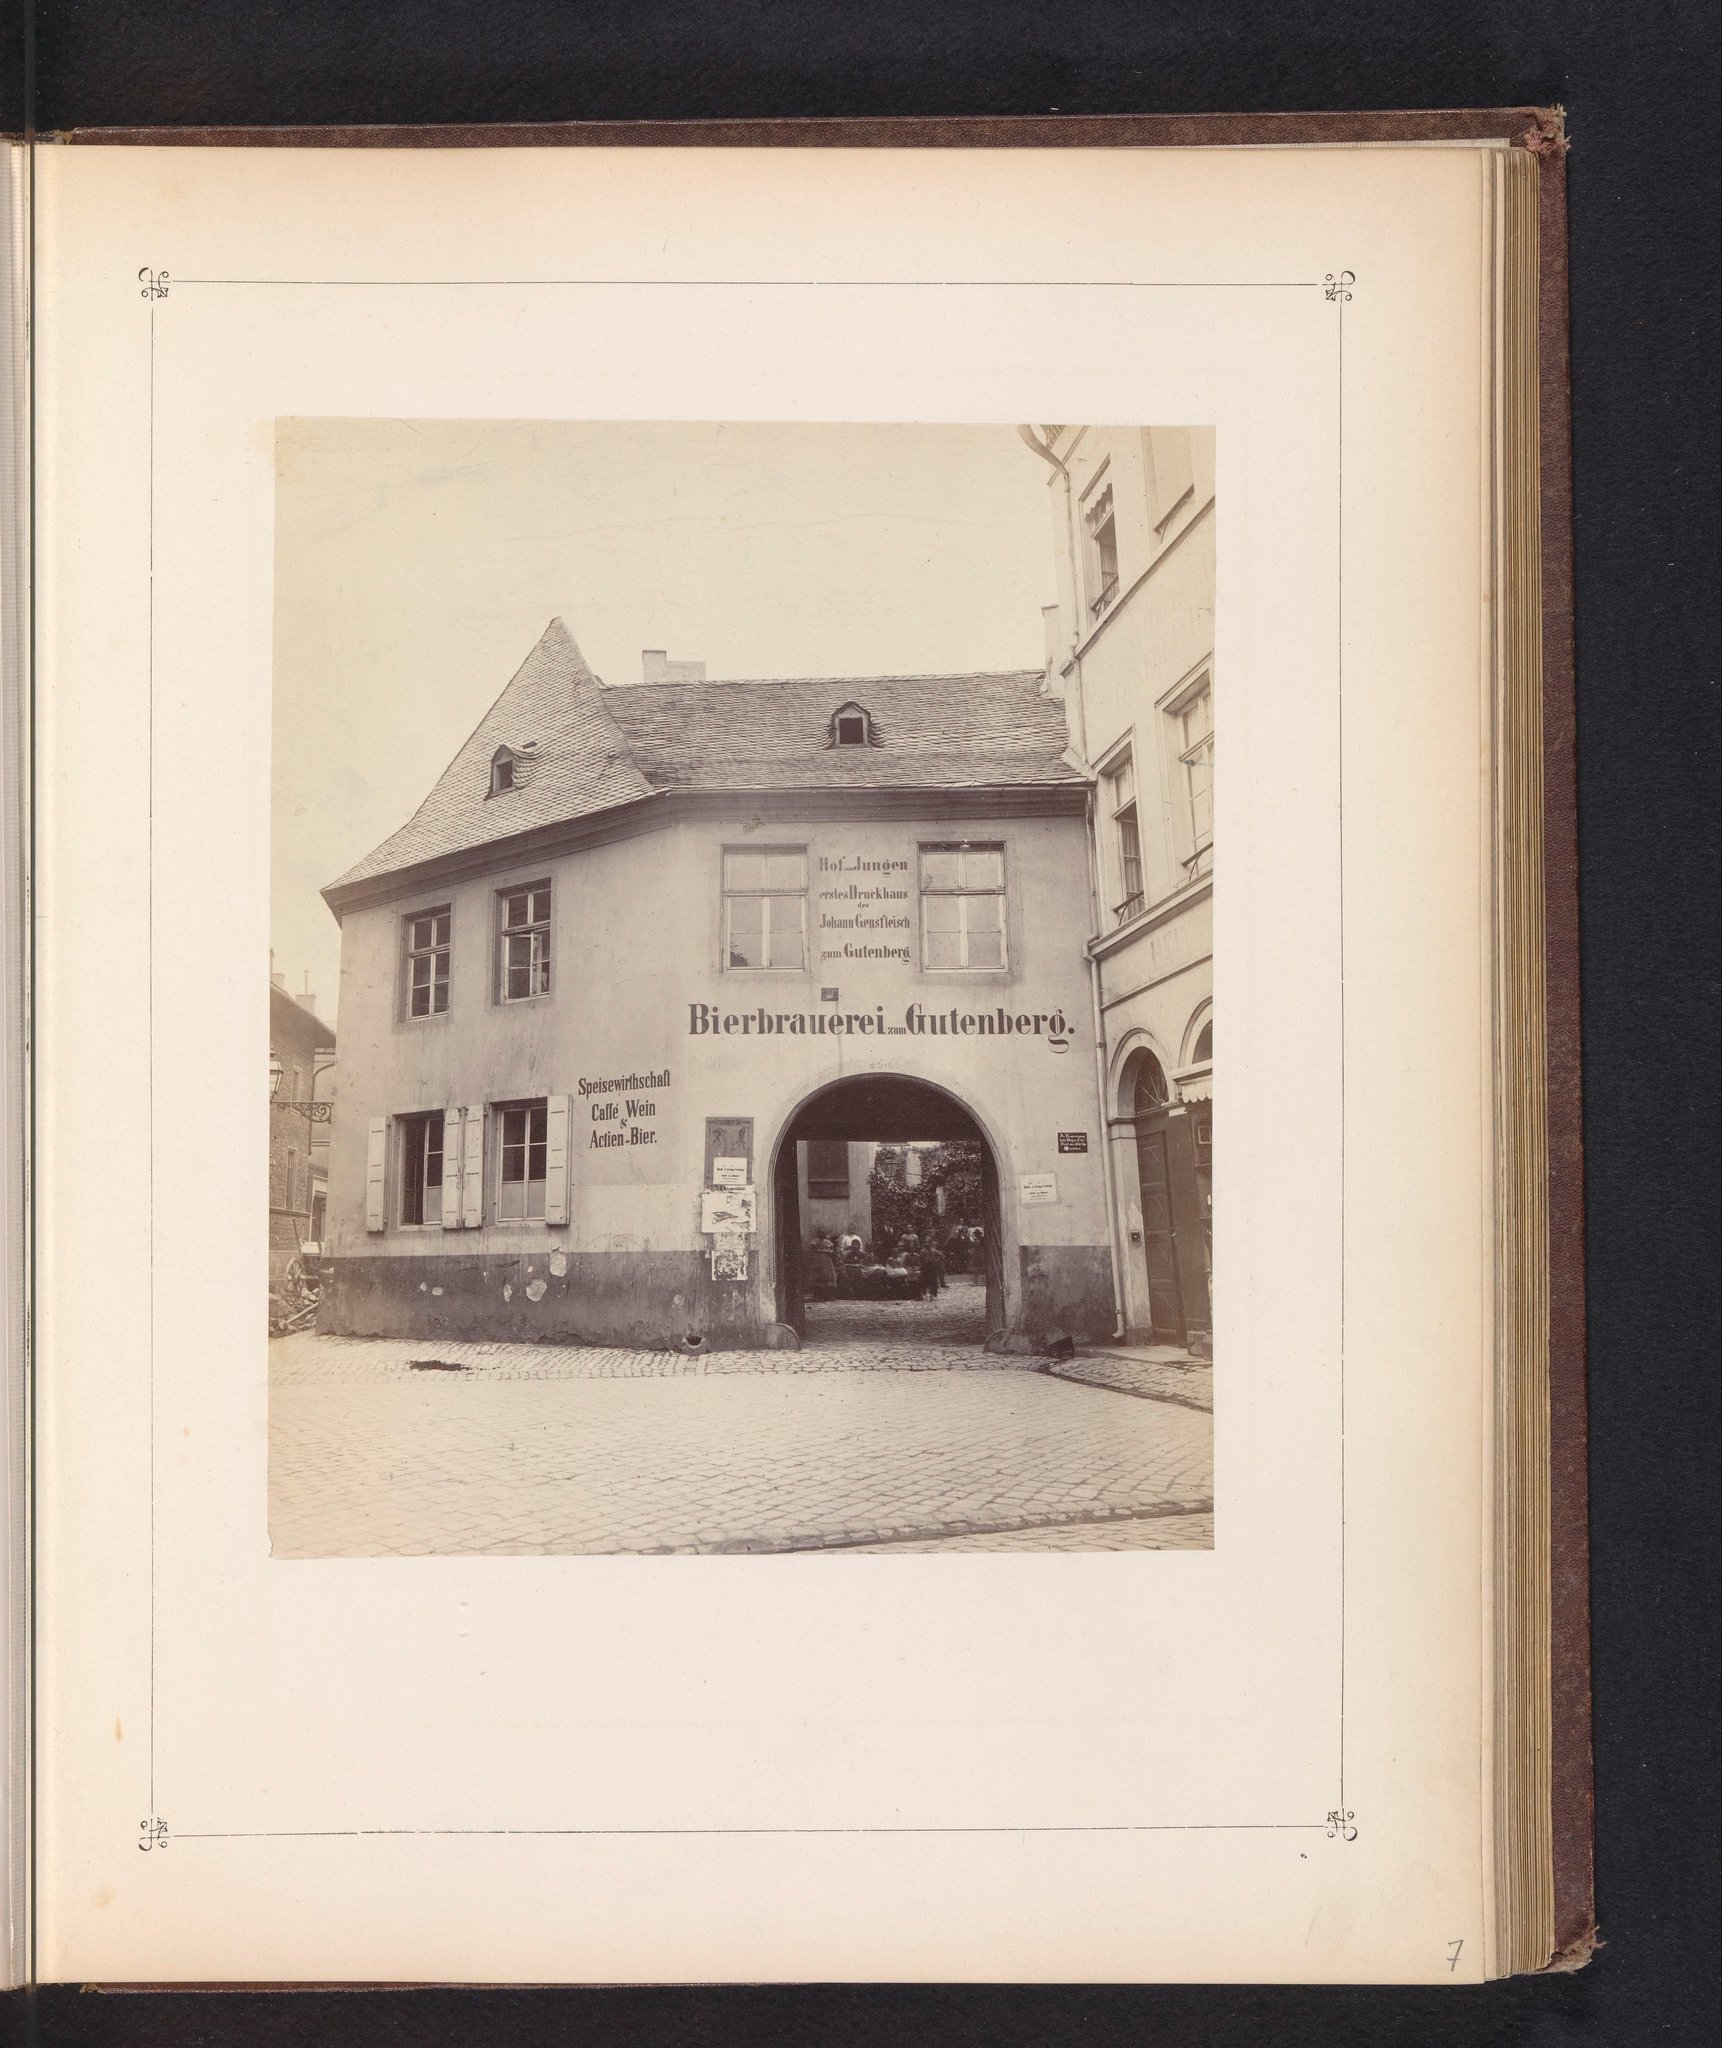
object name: photograph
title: Exterieur van de voormalige drukkerij van Johannes Gutenberg te Mainz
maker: b. erdmann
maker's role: fotograaf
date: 1867-1872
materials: photographic support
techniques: albumen print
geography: mainz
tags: printing, printing office, façade (of house or building)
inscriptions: number: ‘7’